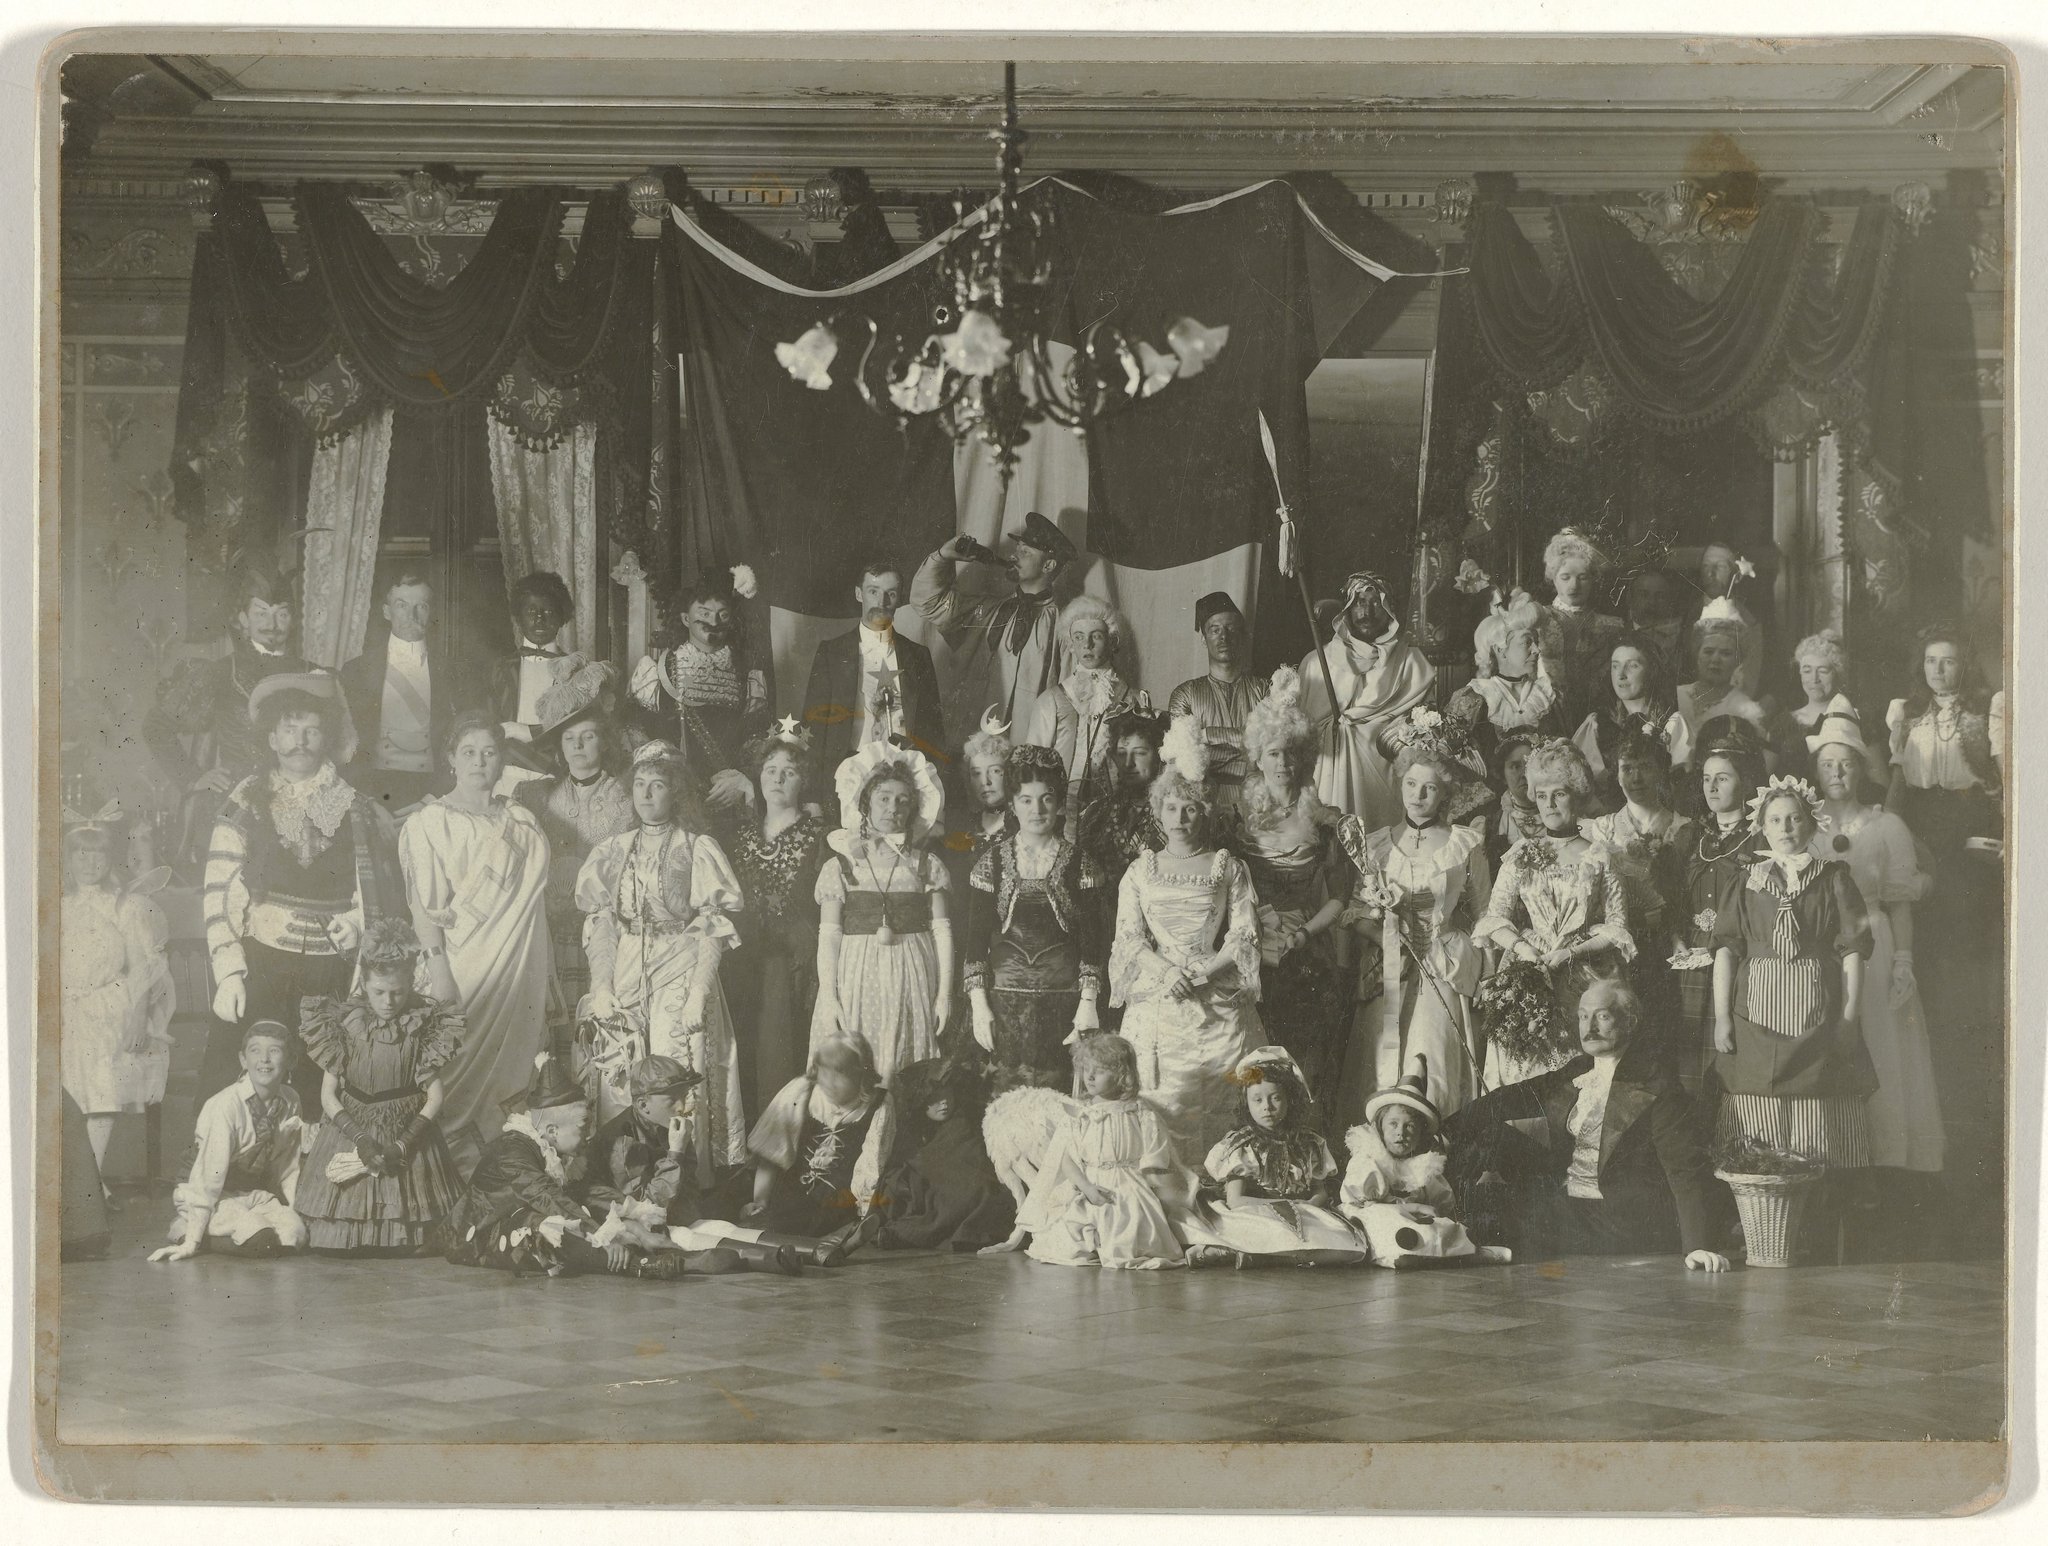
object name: photograph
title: Verkleed gezelschap in een zaal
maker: Anonymous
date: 1908-1920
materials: cardboard, photographic support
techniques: photography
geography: suriname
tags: stage costume, anonymous historical persons portrayed in a group, in a group-portrait, suriname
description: Verkleed gezelschap poserend voor een groepsportret in een zaal, vermoedelijk naar aanleiding van een toneelvoorstelling of feest. Onderdeel van een groep foto's van de familie Boom-Gonggrijp in Suriname.